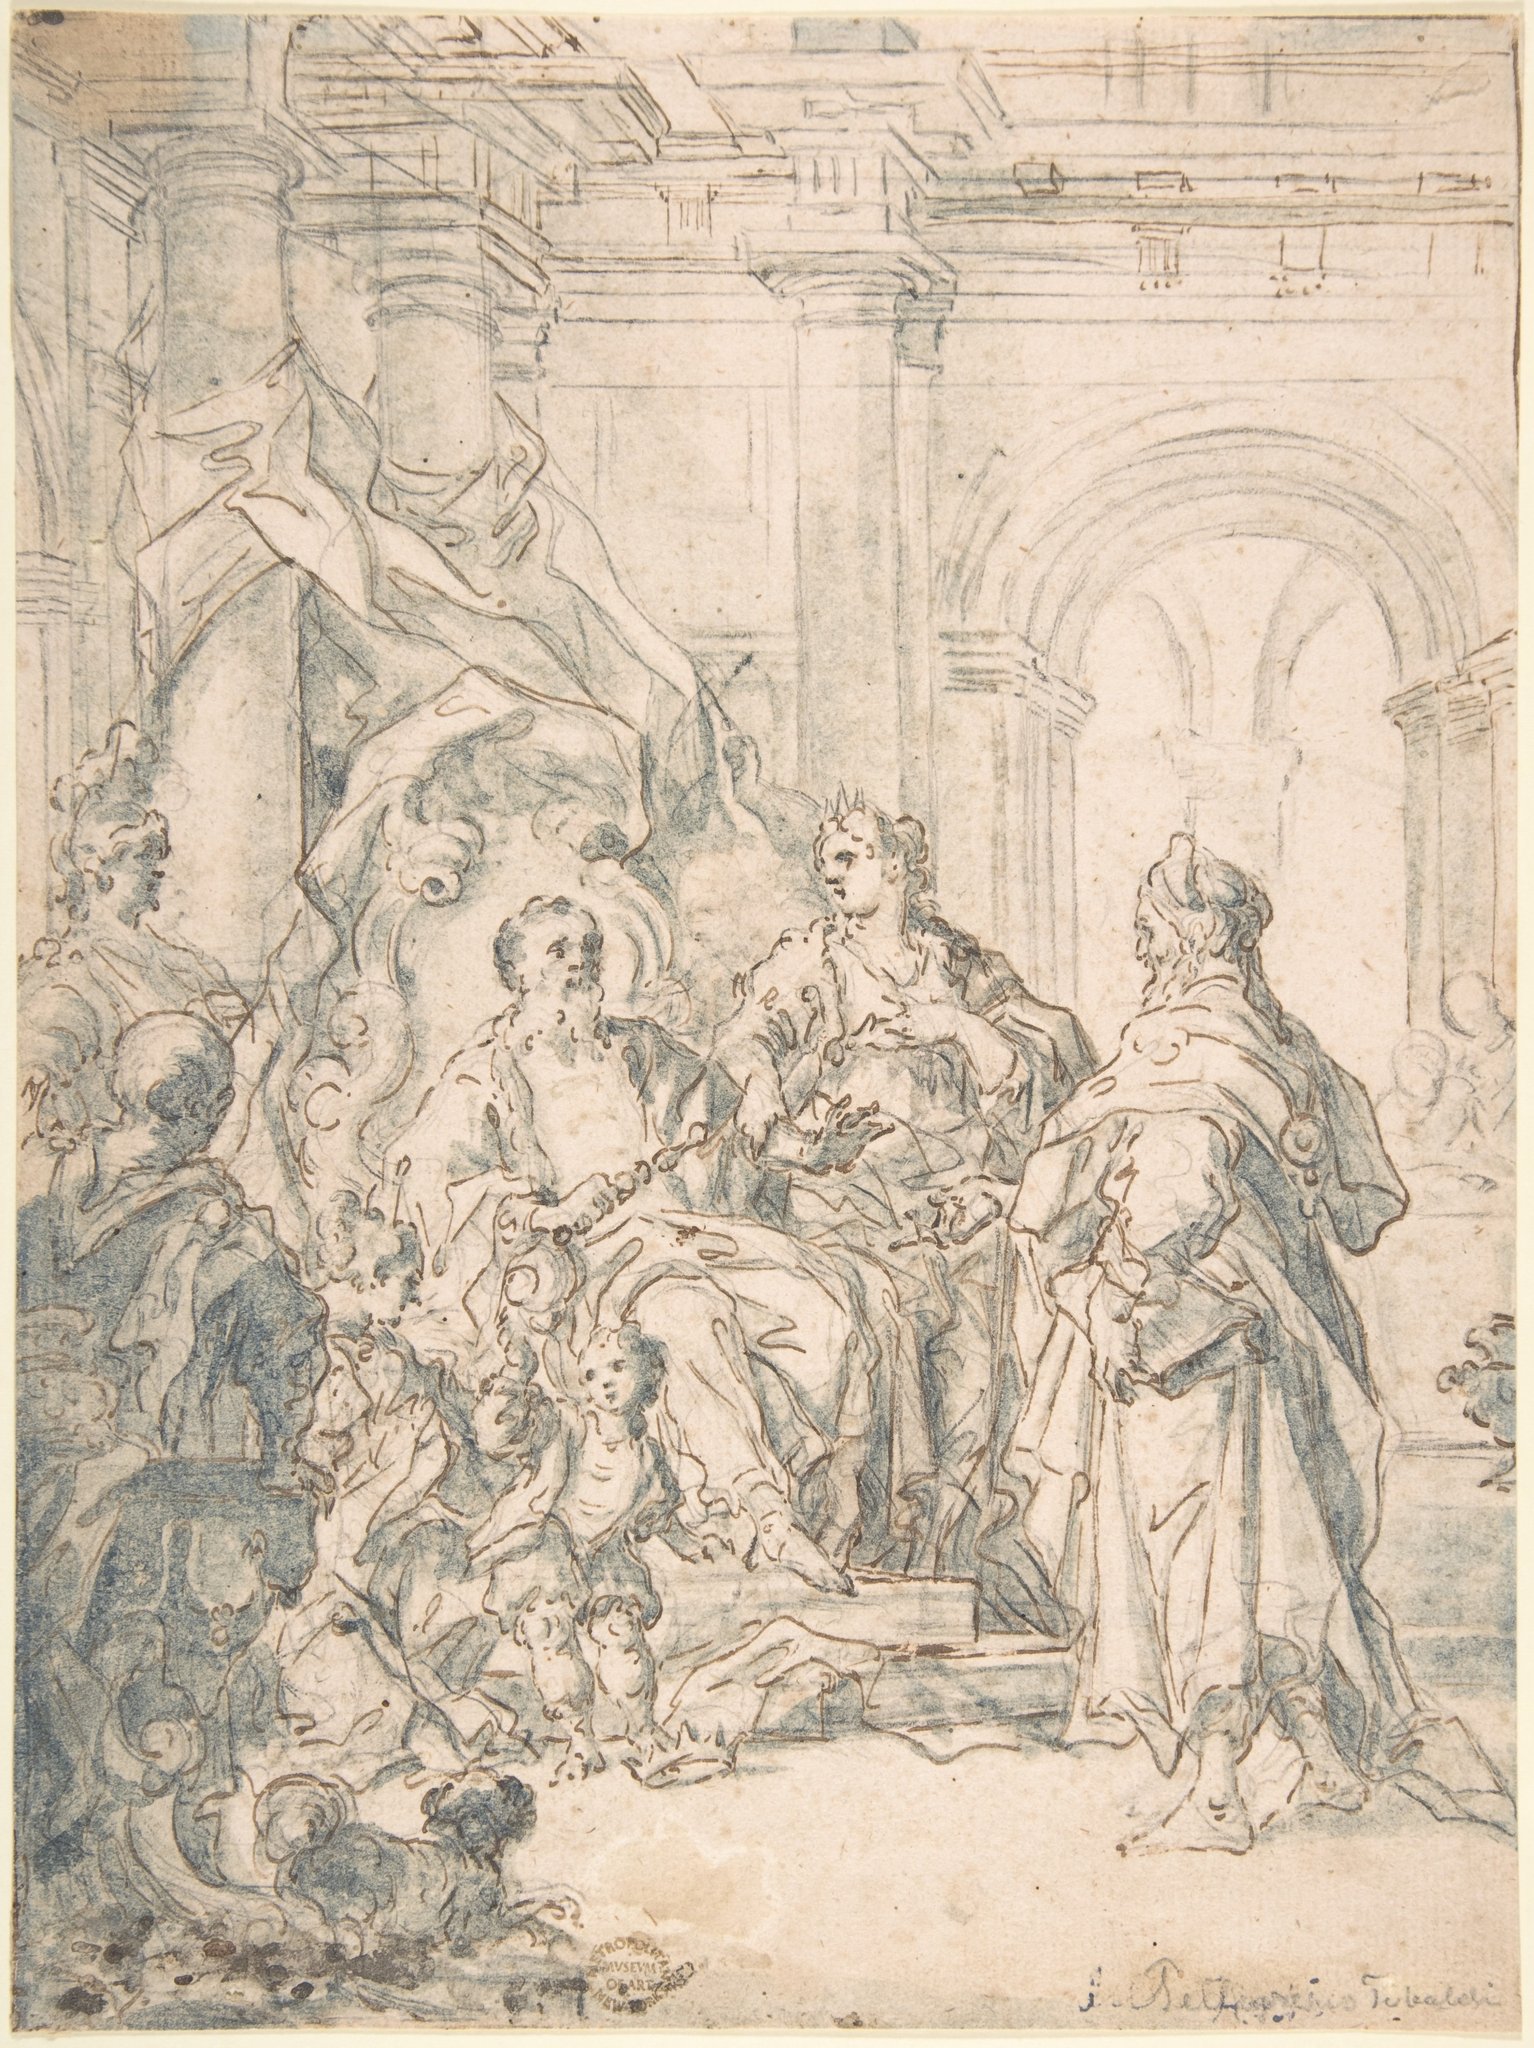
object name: drawing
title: An Audience (recto); Sketch of a nude woman (verso)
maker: anonymous, italian, roman-bolognese, 17th century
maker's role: artist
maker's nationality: italian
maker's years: 1600-1700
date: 1601-1700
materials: chalk, ink, paper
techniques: brush, pen, wash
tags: children,men,women